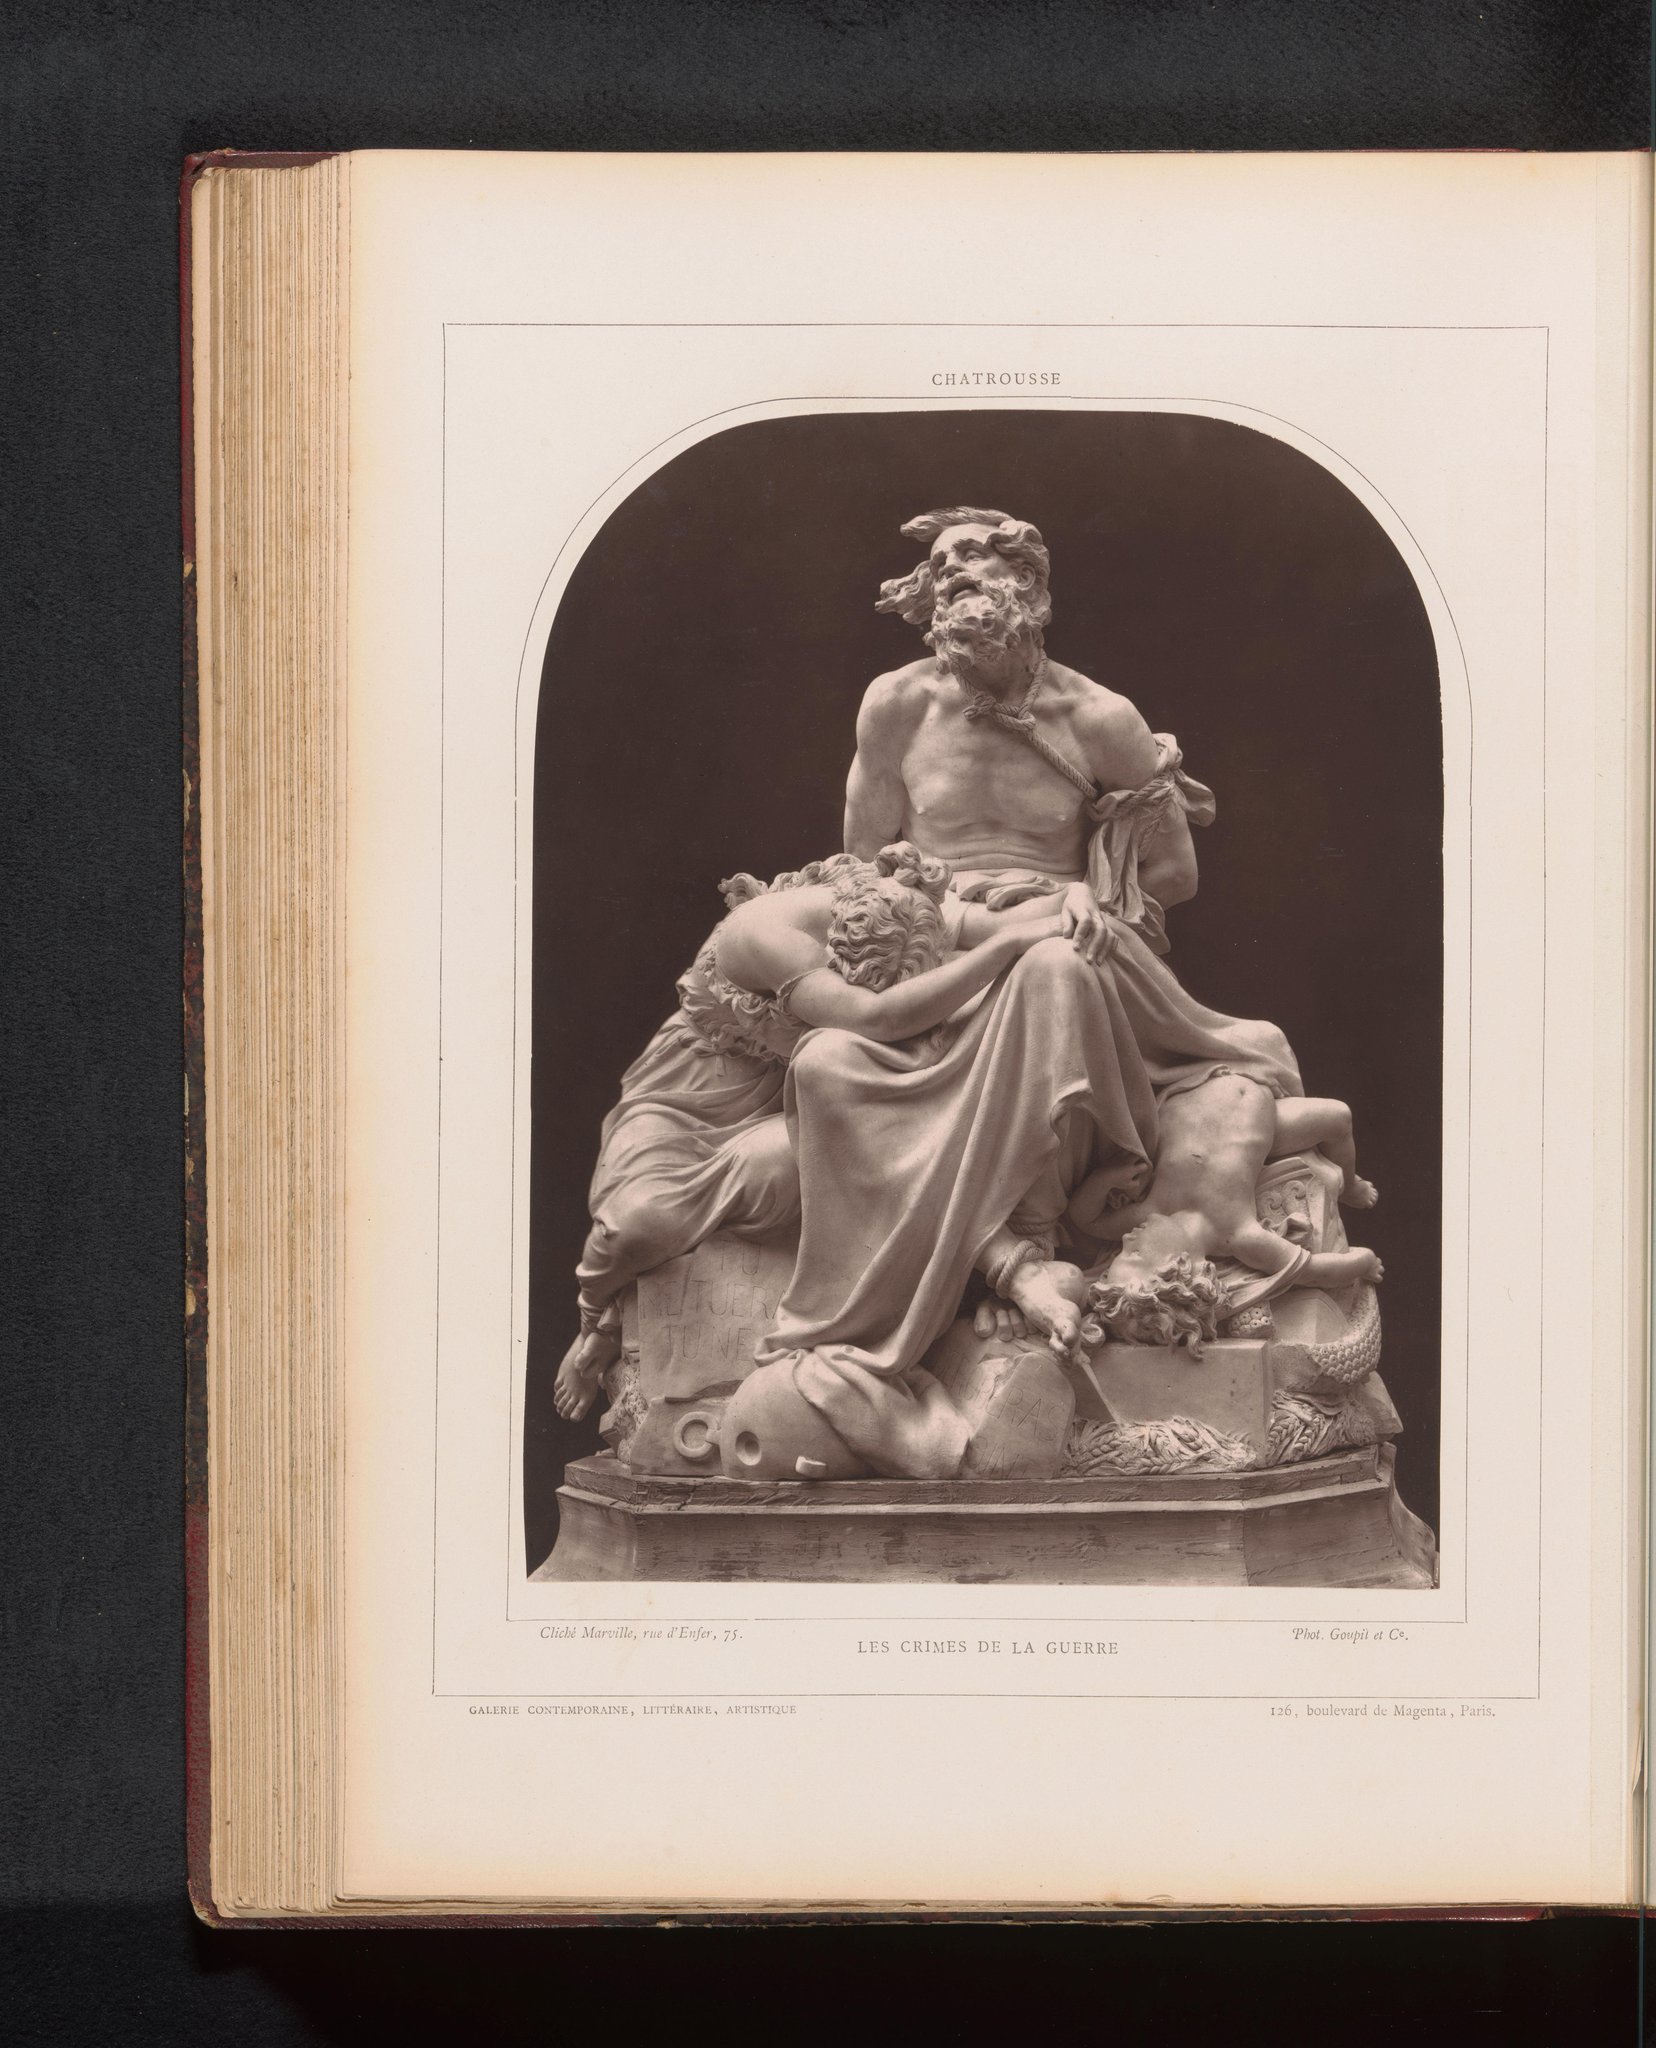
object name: photomechanical print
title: Les crimes de la guerre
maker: charles marville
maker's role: print maker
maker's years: 1816-1879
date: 1867-1877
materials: paper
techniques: woodburytype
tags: historical persons, sculpture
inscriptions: inscription: ‘Galerie Contemporaine, Littéraire, Artistique/ 126, boulevard de Magenta, Paris.’